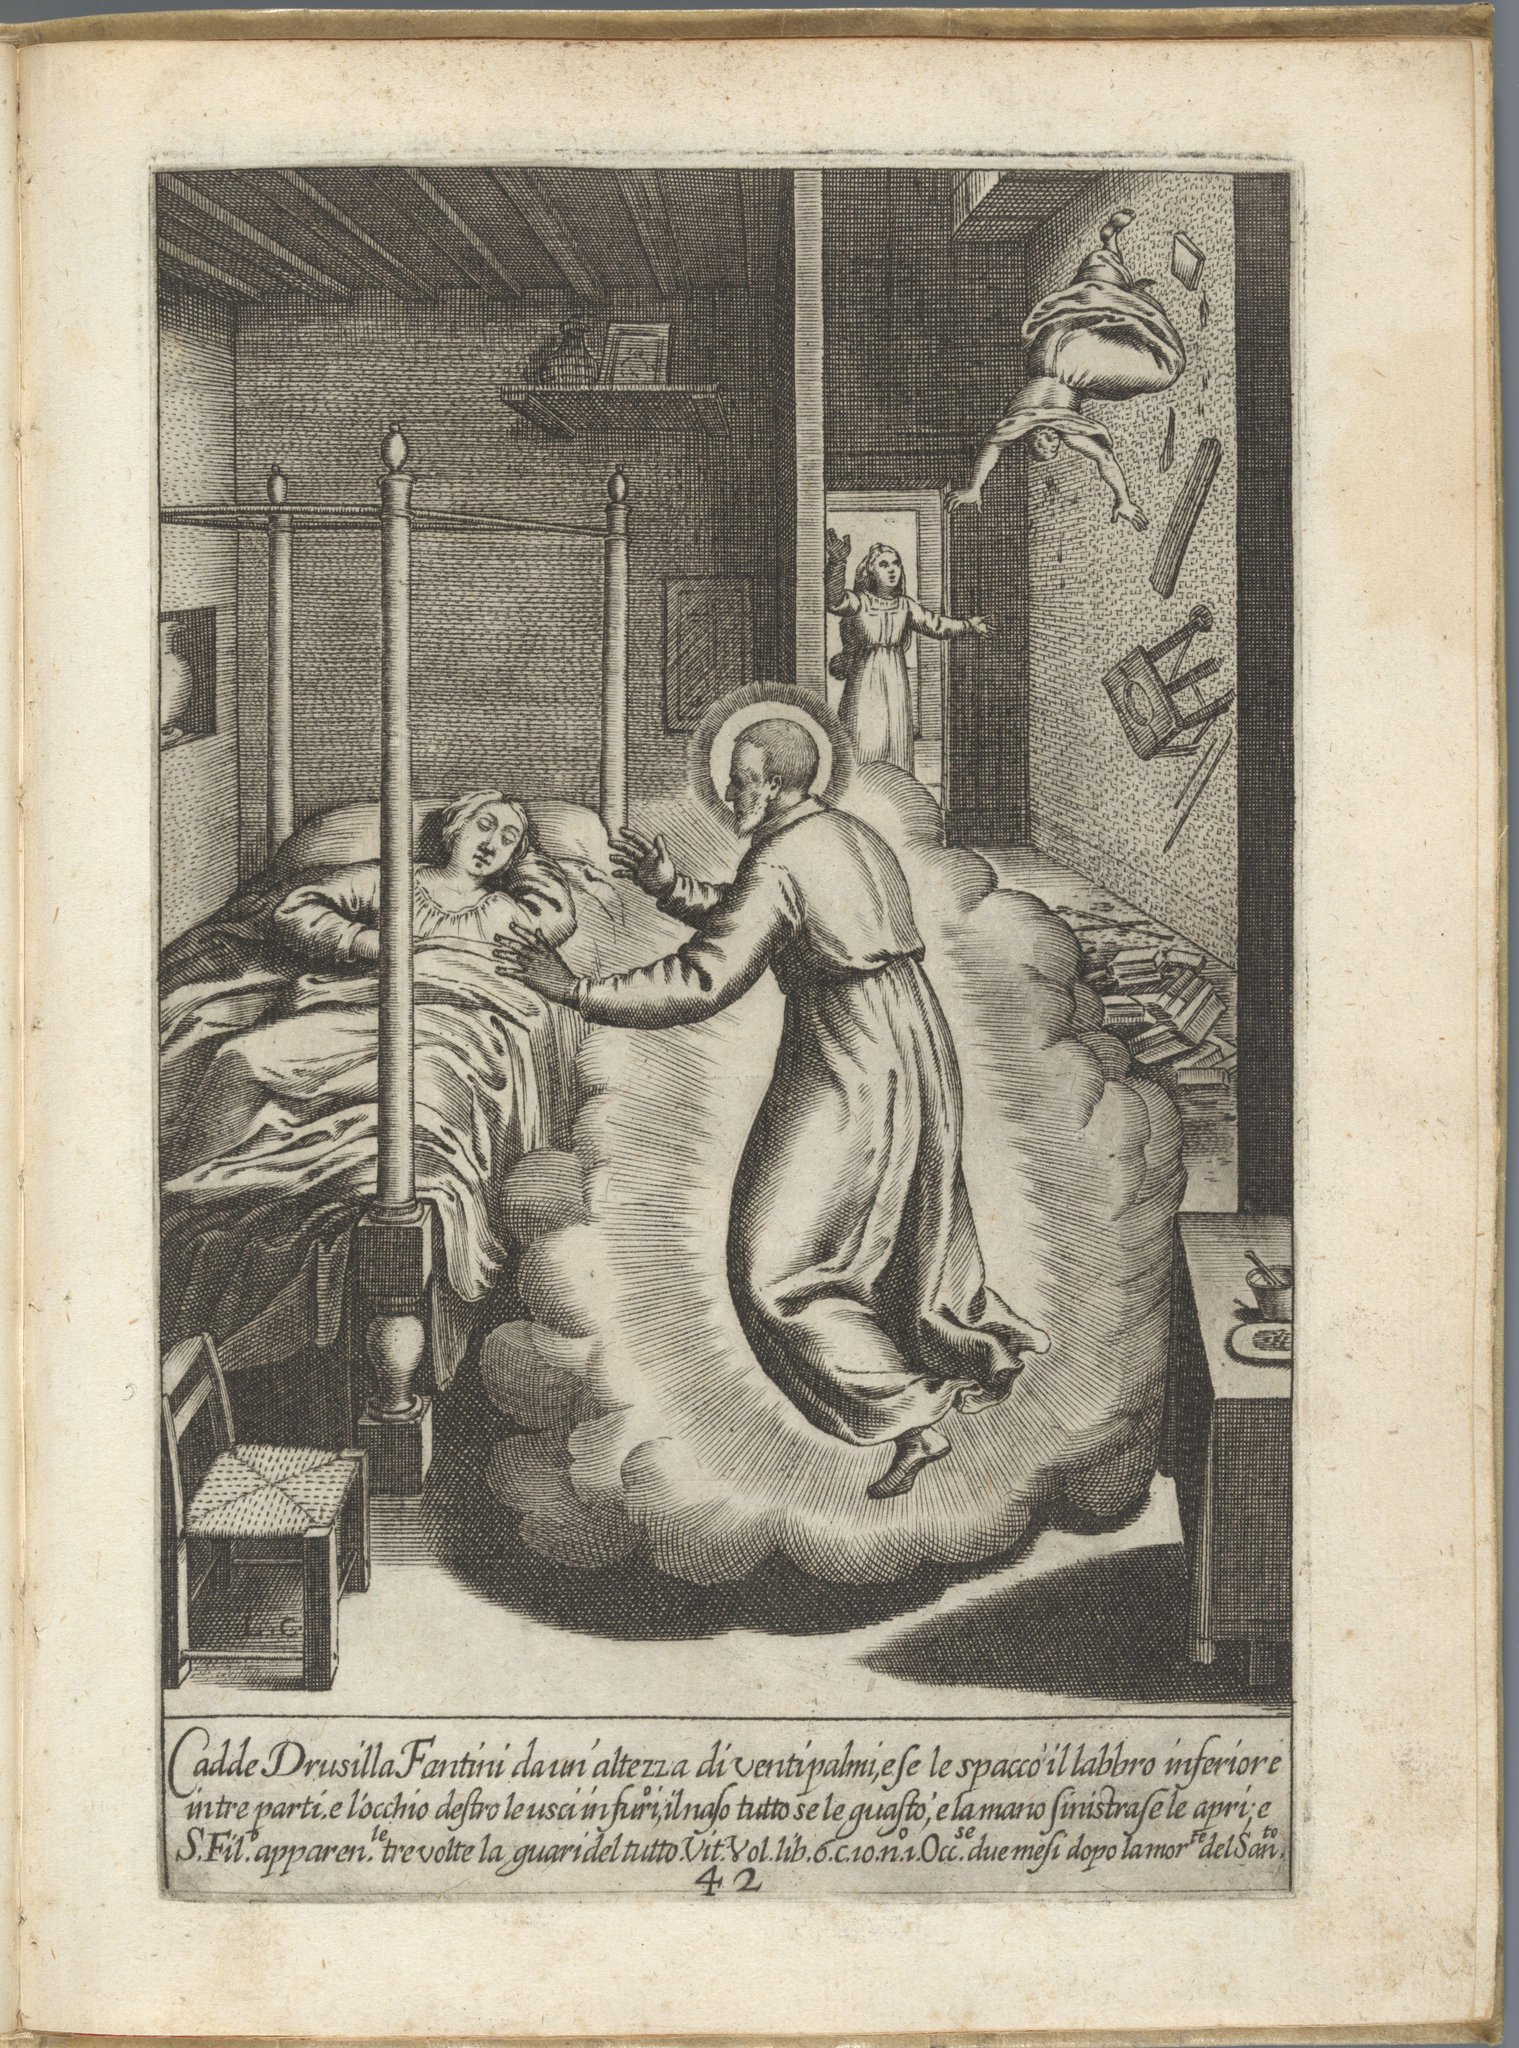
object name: print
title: Leven van de heilige Filippo Neri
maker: luca ciamberlano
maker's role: painter, print maker, publisher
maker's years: 1570-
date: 1630-1641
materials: paper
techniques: engraving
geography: rome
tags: the founder of the congregation of the oratory (oratorians) philip neri; possible attributes: lily, rosary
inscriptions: collector's mark: Lugt 2228, collector's mark: Lugt 2760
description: Verschijning van Filippo Neri aan Drusilla Fantini en haar wonderlijke genezing. Prent nr. 42 in een serie van 44 prenten met scènes uit het leven van de heilige Filippo Neri.